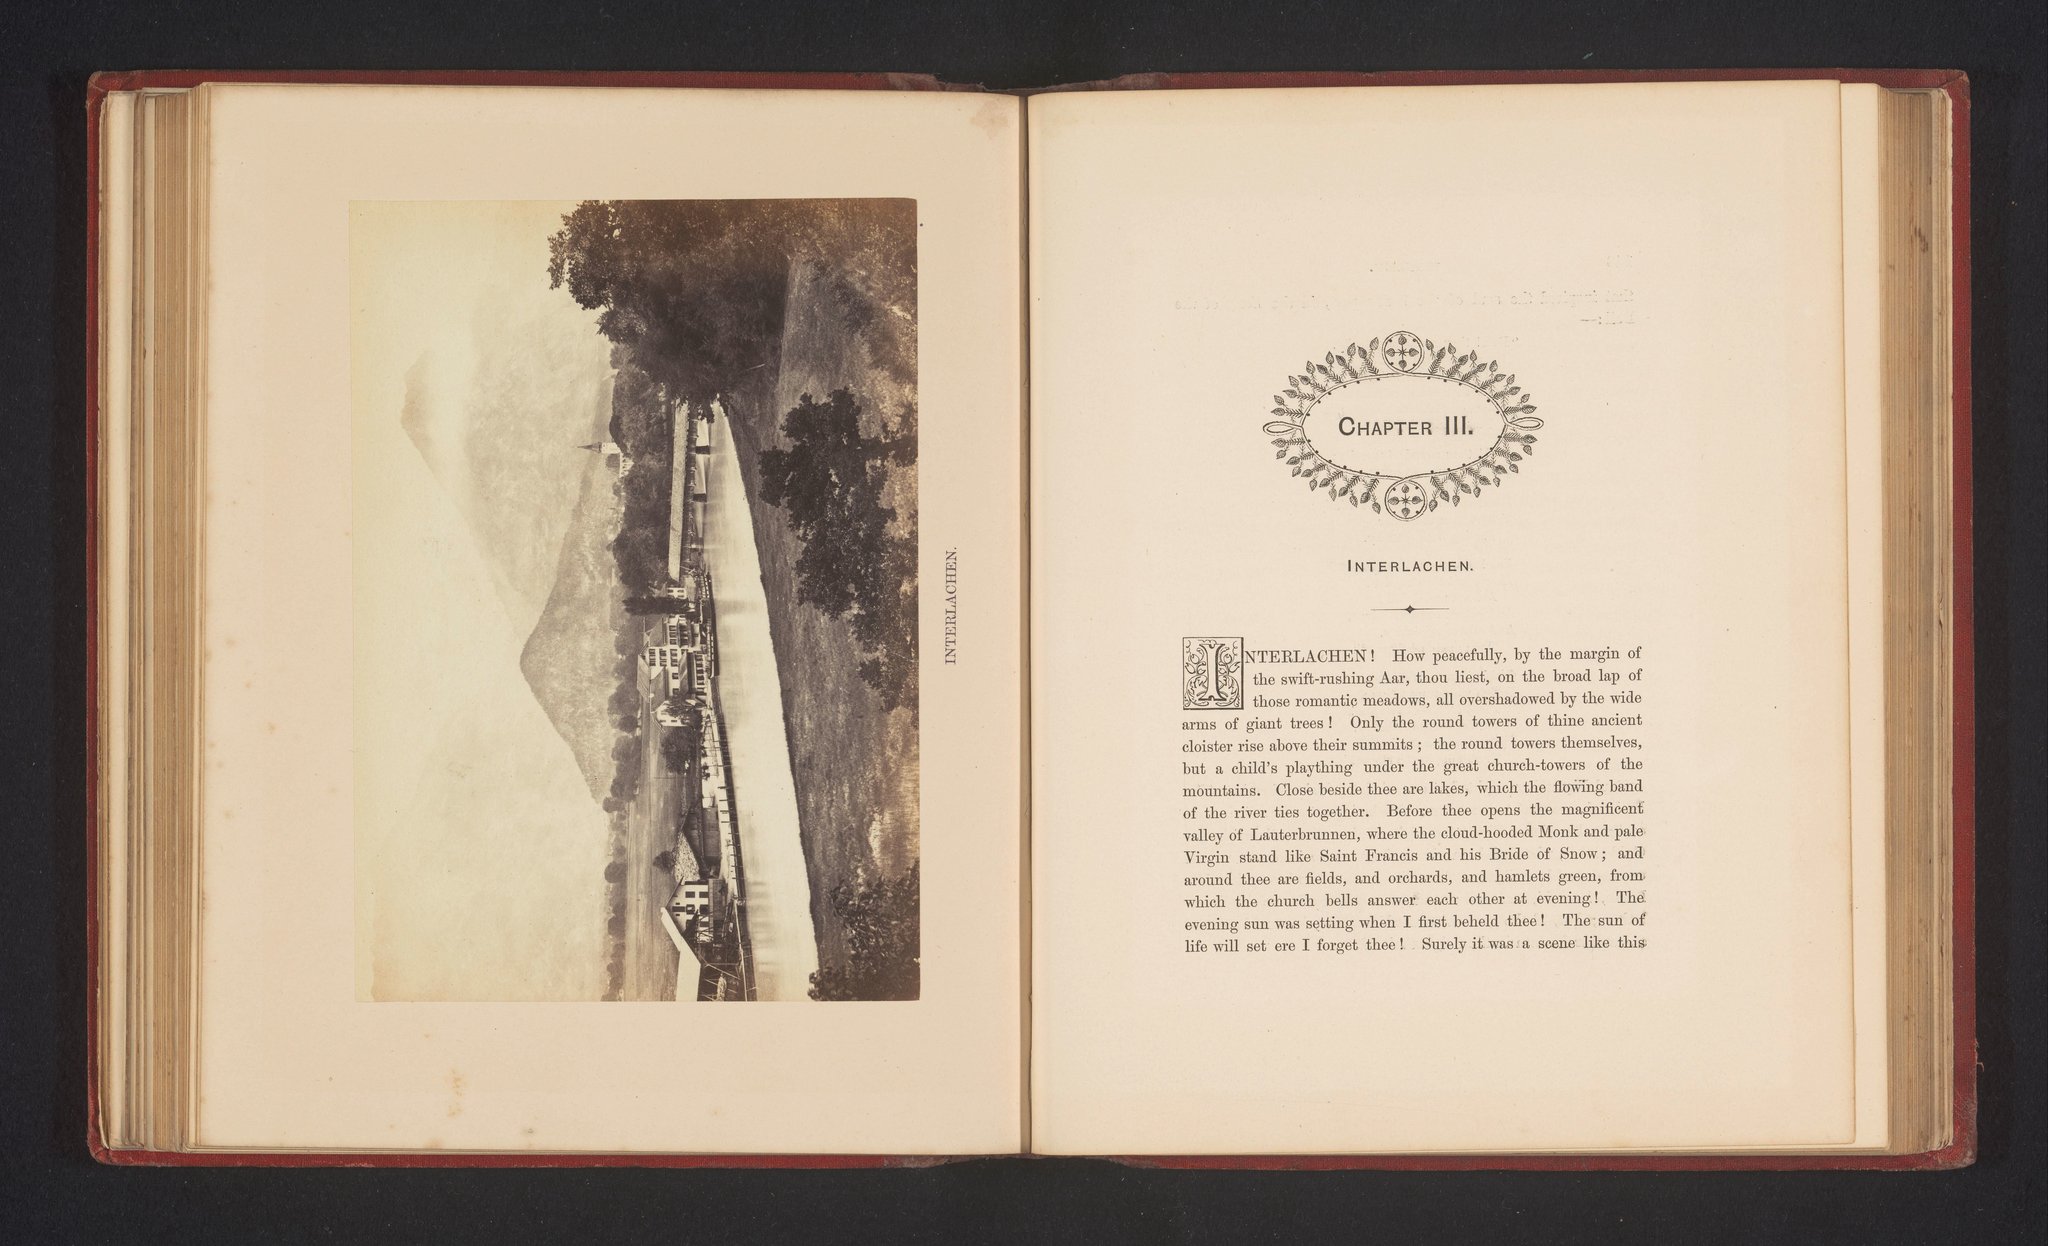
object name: page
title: Gezicht op Interlaken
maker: francis frith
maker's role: publisher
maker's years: 1822-1898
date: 1855-1865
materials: photographic support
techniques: albumen print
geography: interlaken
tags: city-view, and landscape with man-made constructions, lake, parts of church exterior and annexes: tower, mountains